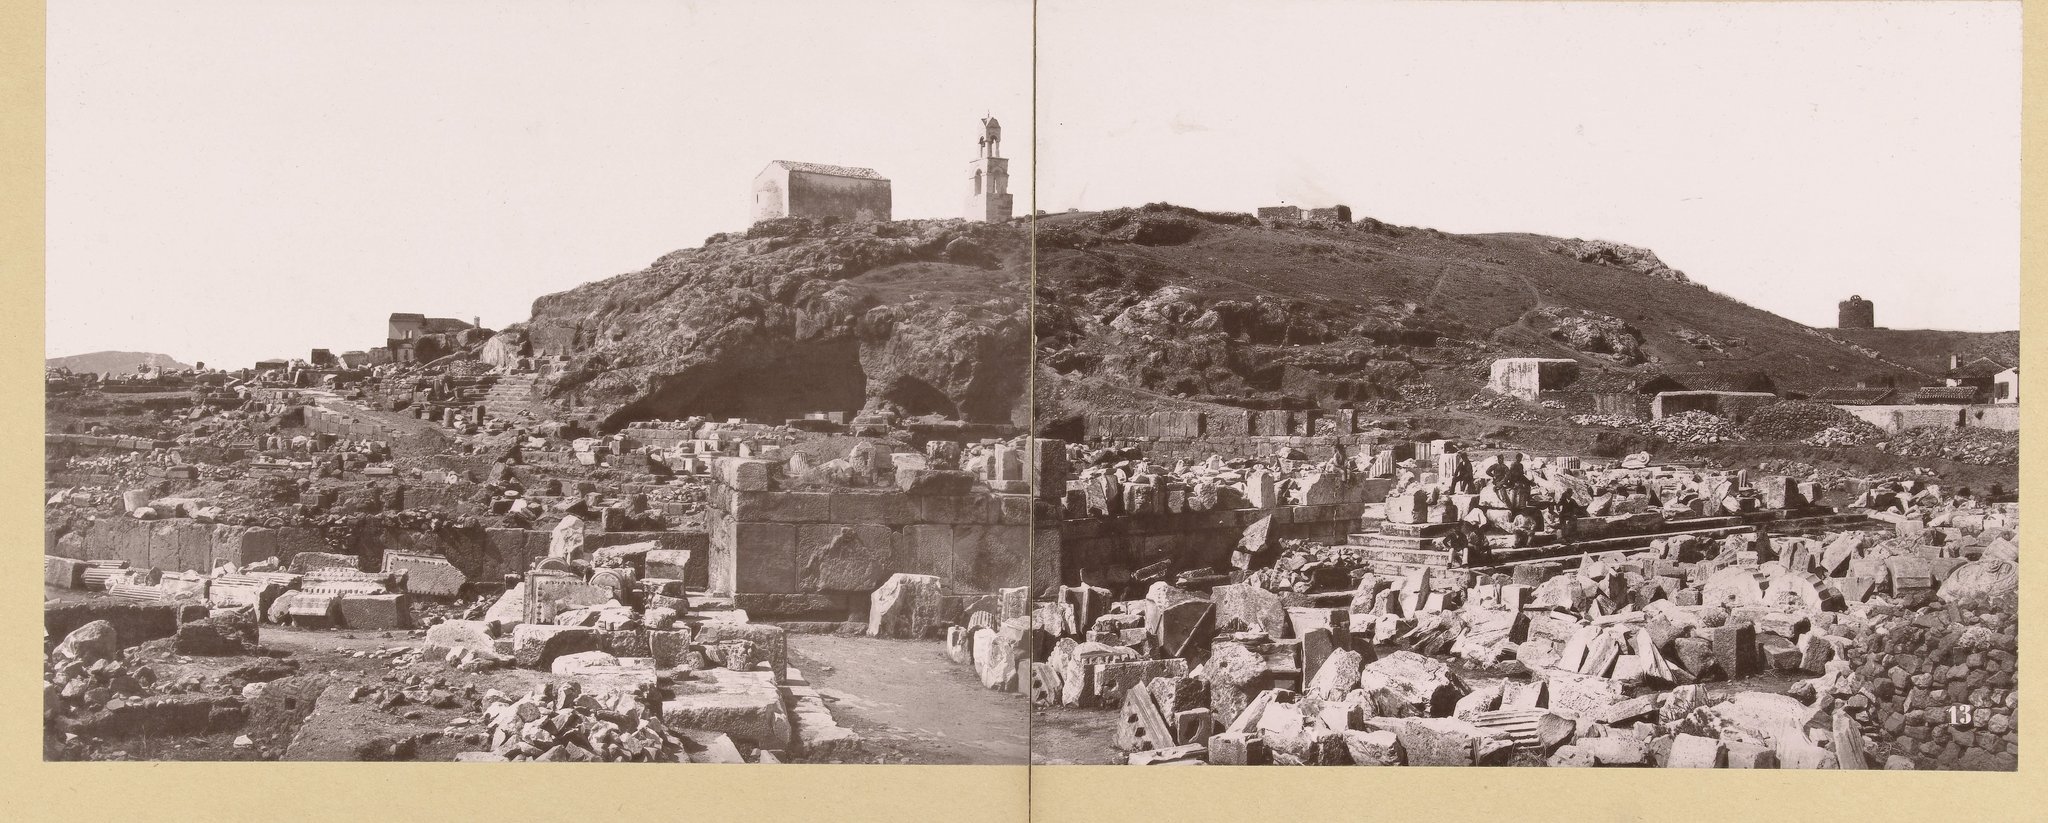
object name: photomechanical print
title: G 46. Panorama van de ruïnen van Eleusys aan de baai van Salamis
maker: Anonymous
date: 1890-1895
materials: cardboard, paper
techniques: photograph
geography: elefsina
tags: ruin of a building ~ architecture, landscape with ruins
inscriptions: check stamp: ‘Bristol/ L.M.’, stamp: ‘Gemeentelijke bibliotheek/ Rotterdam’, check stamp: ‘Bristol/ L.M.’, inscription: ‘G 46. Panorama van de ruïnen van Eleusys aan de baai van Salamis./ (Hier werden de mysteriën gehouden).’, number: ‘13’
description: Onderdeel van een groep door fotograaf Richard Polak op reis verzamelde foto’s. Deze fotomechanische afdruk is samen met andere op zijn reizen verzamelde foto's tentoongesteld bij de Rotterdamsche Kunstkring (1895), Arti en Amicitiae te Amsterdam (1897-1898?) en Societeit 't Collegie te Kampen (datum vooralsnog onbekend).